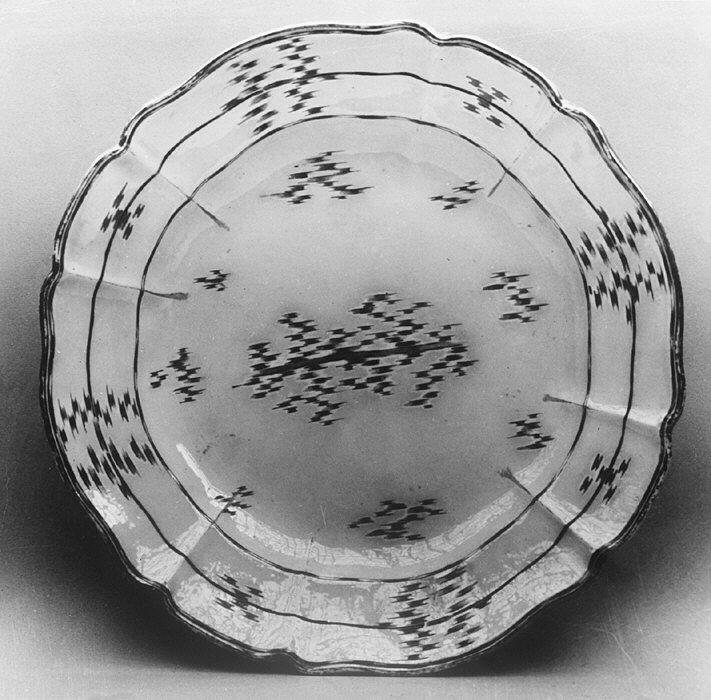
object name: plate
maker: nymphenburg porcelain manufactory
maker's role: manufactory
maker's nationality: german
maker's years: 1747-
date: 1770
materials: hard paste porcelain